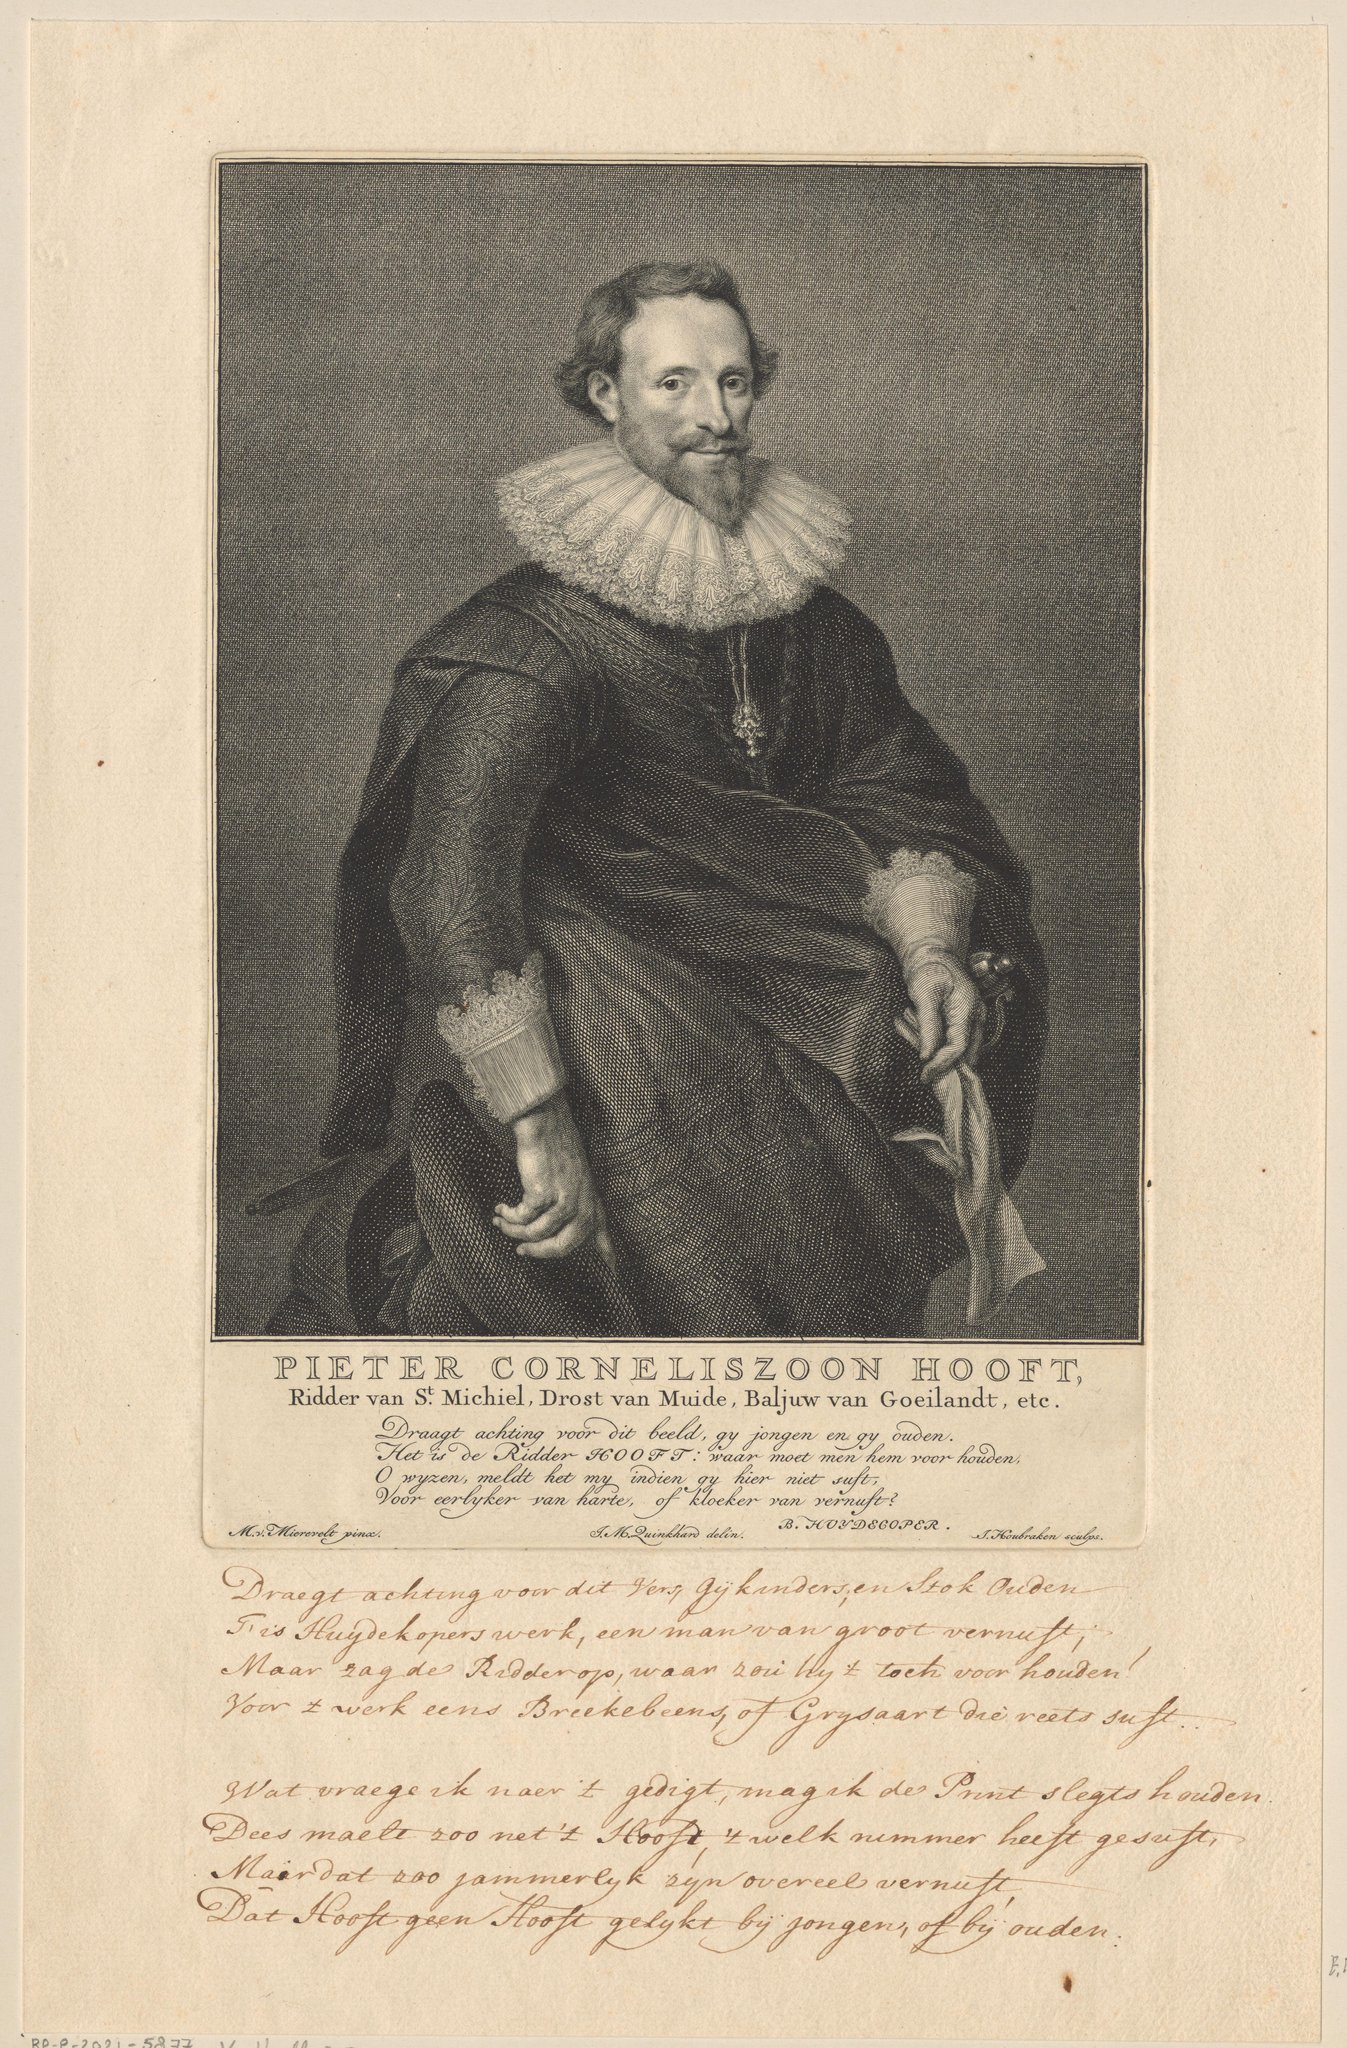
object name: print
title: Portret van Pieter Corneliszoon Hooft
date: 1708-1790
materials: paper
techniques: engraving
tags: amsterdam, the hague, pieter corneliszoon hooft, historical persons, writer, poet, author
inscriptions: inscription: ‘Draegt achtung voor dit vers, gijkanders en stok ouden/ T'is Huydekopers werk, een man van groot vernuft/ Maar zag de Ridder op, waar zou hij 't toch voor houden!/ Voor 't werk een Breekebeens, of Grysaart die reeds suft../ Wat vraege ik naer 't gedigt, mag ik de Print slegts houden/ Dees maele zoo net 't Hooft, 't welk nummer heeft heeft gesuft,/ Maar dat zoo jammerlyk zyn overeel vernuft/ Dat Hooft geen Hooft gelykt bij jongen, of bij ouden.’